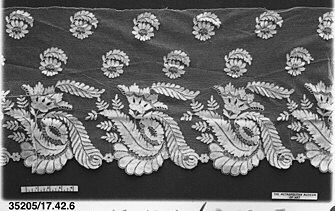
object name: fragment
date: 1801-1900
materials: lace, silk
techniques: lace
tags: flowers,leaves